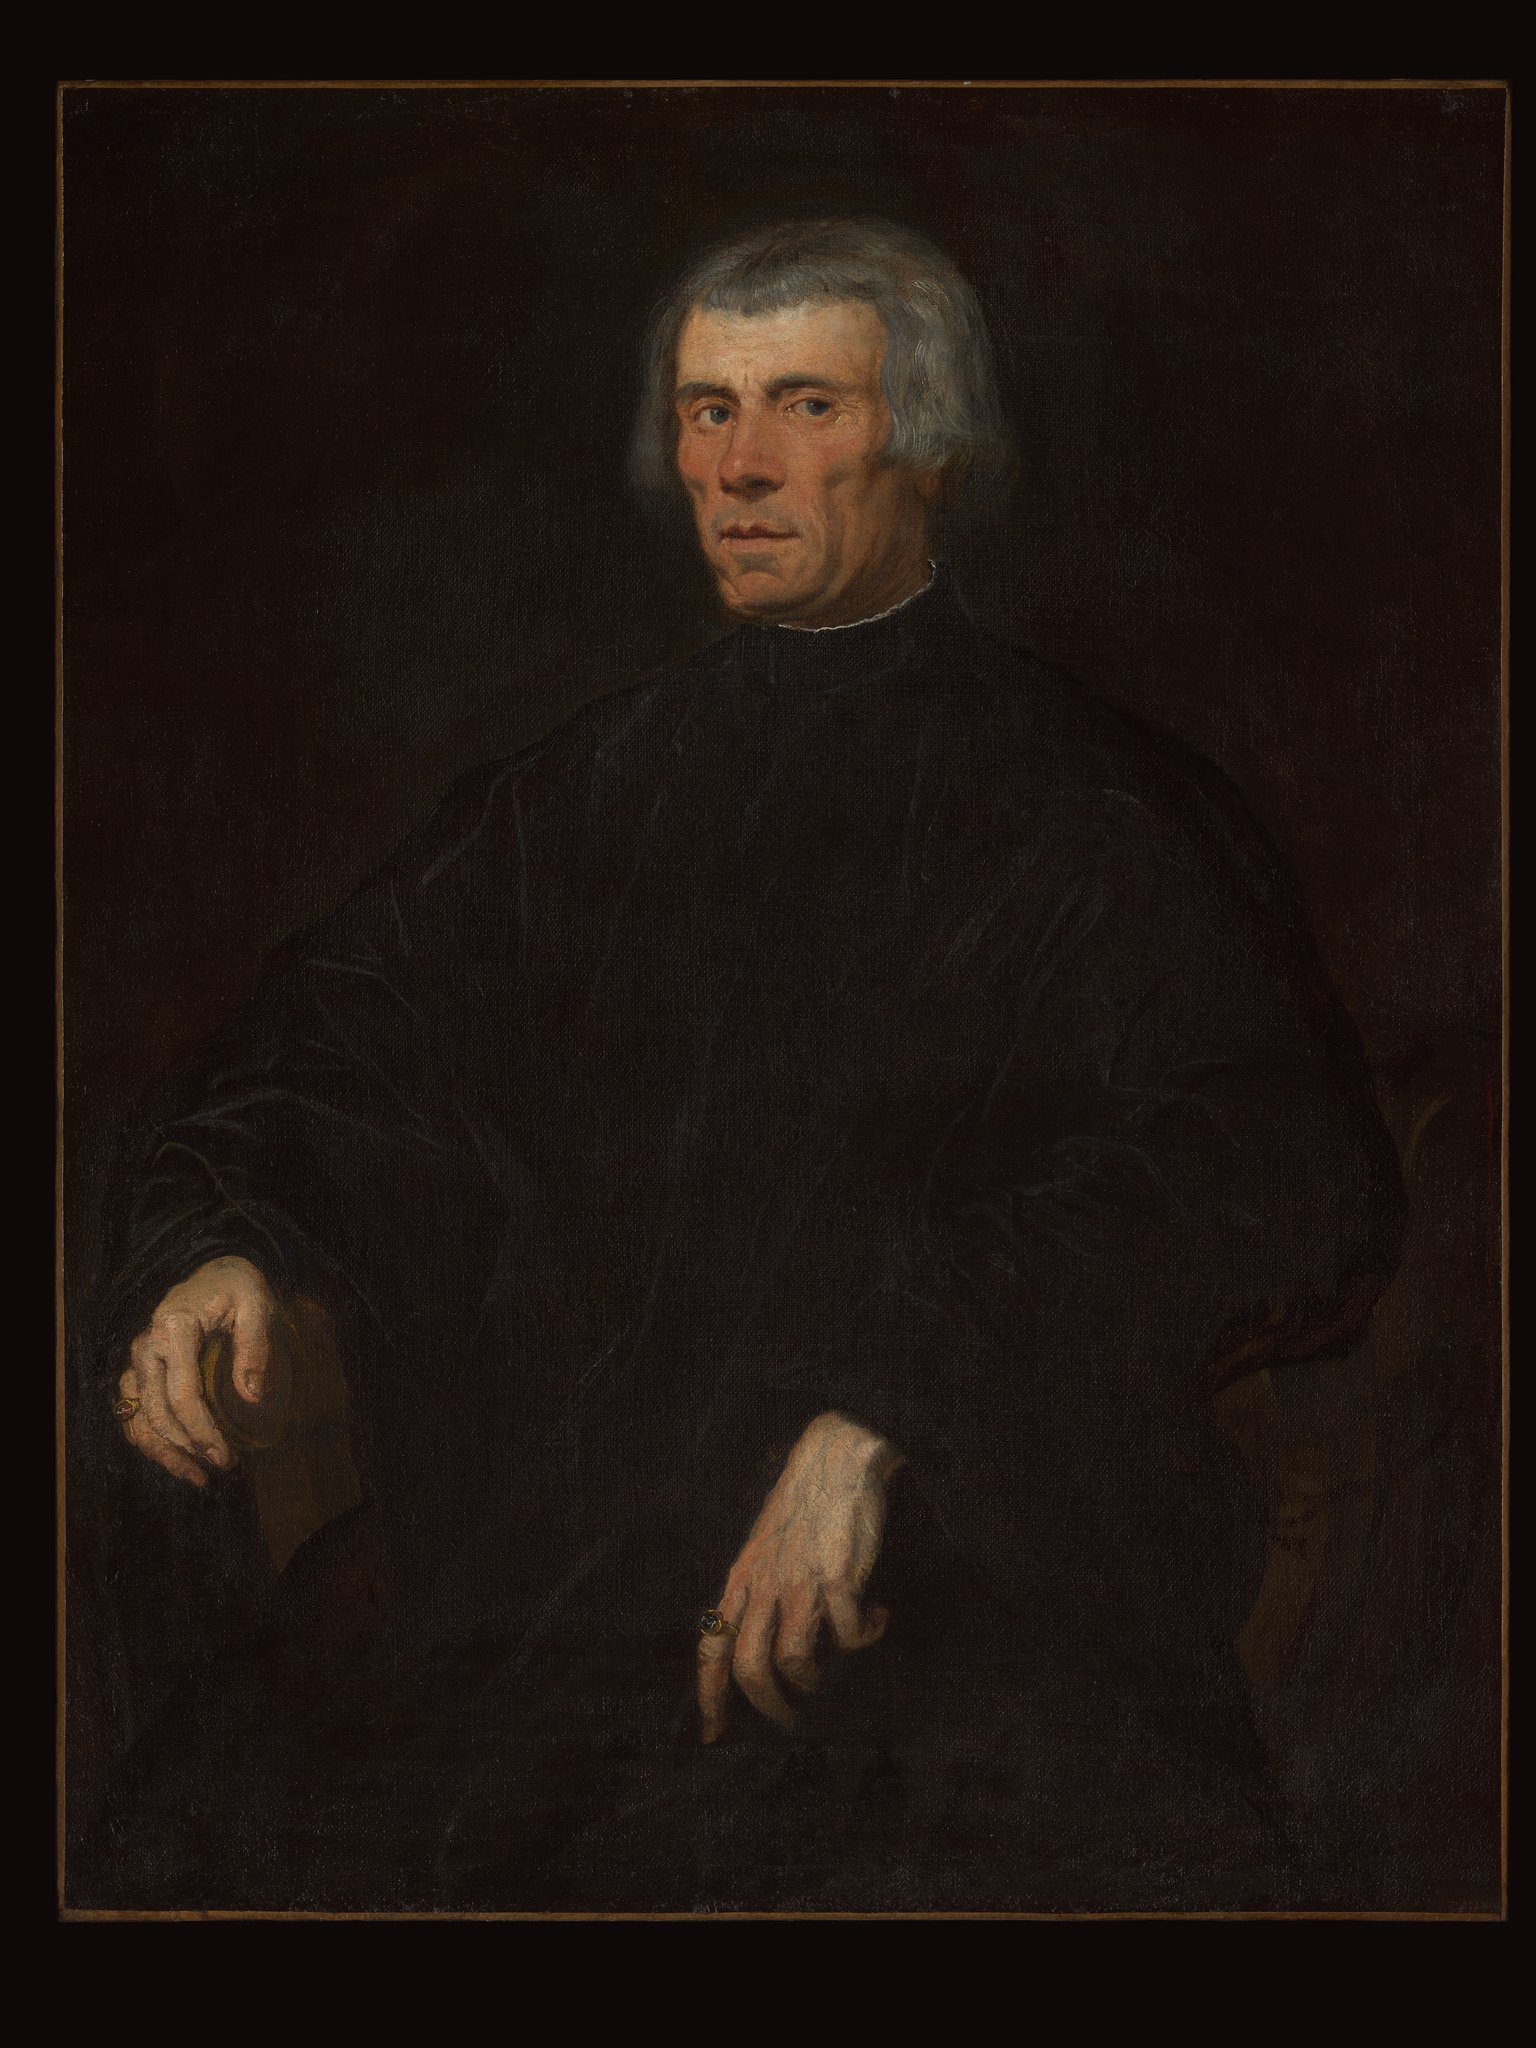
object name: painting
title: Portrait of a Man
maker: jacopo tintoretto (jacopo robusti)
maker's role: artist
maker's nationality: italian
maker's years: 1518-1594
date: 1550-1559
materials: canvas, oil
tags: men,portraits